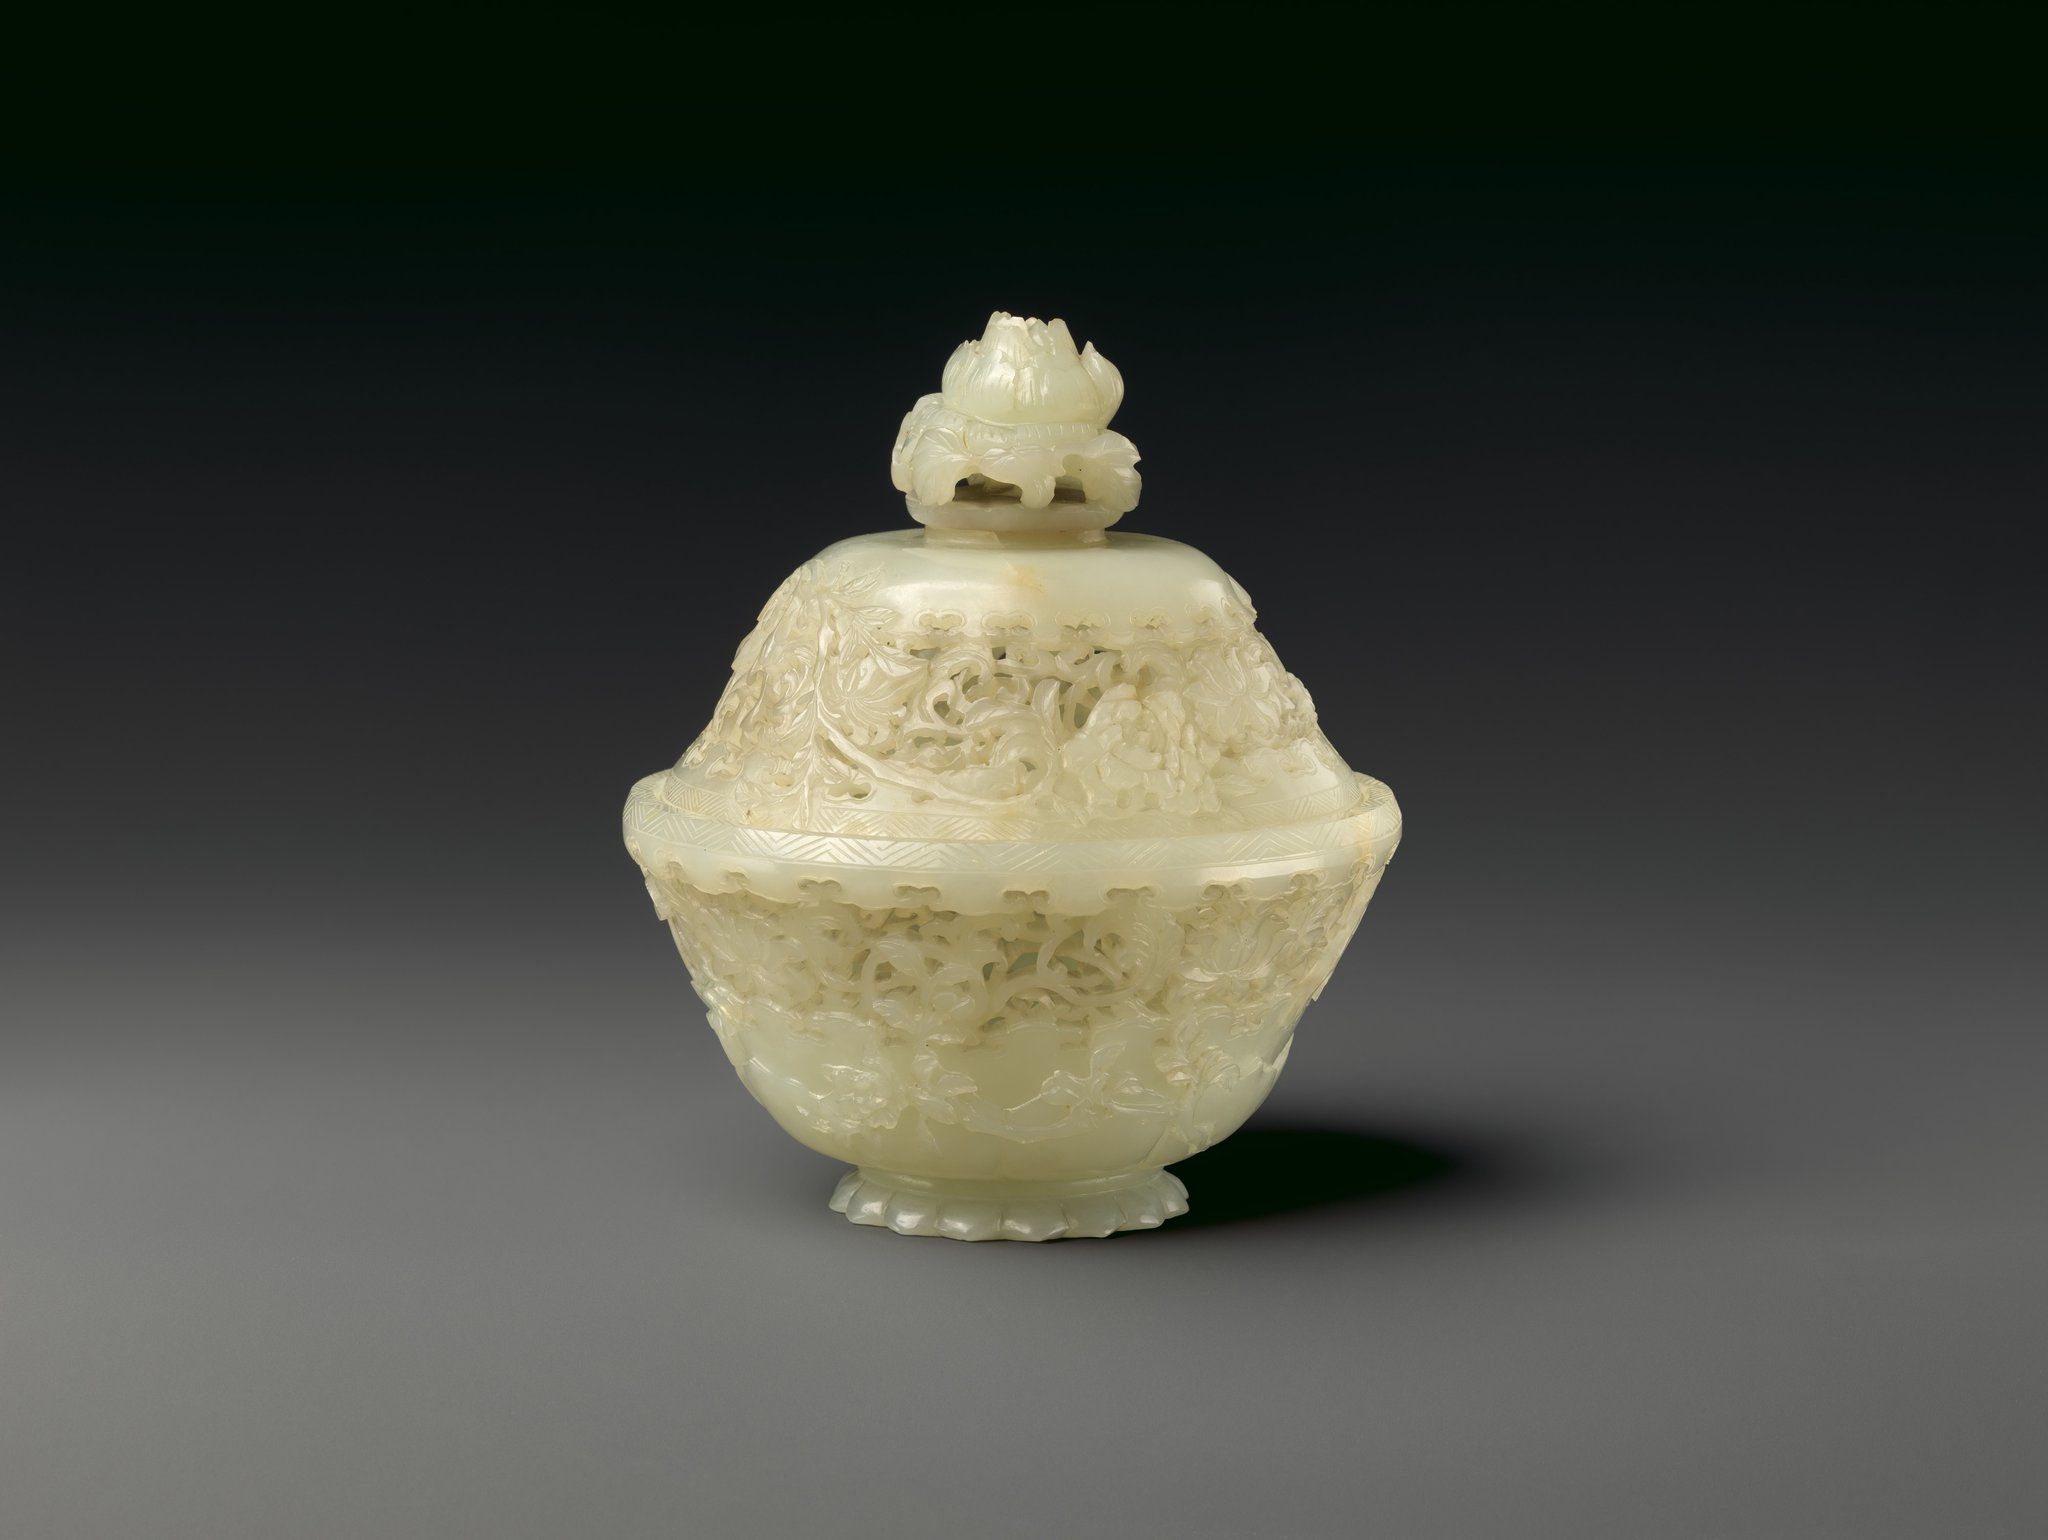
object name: bowl with cover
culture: chinese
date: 1736-1795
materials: jade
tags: flowers,leaves